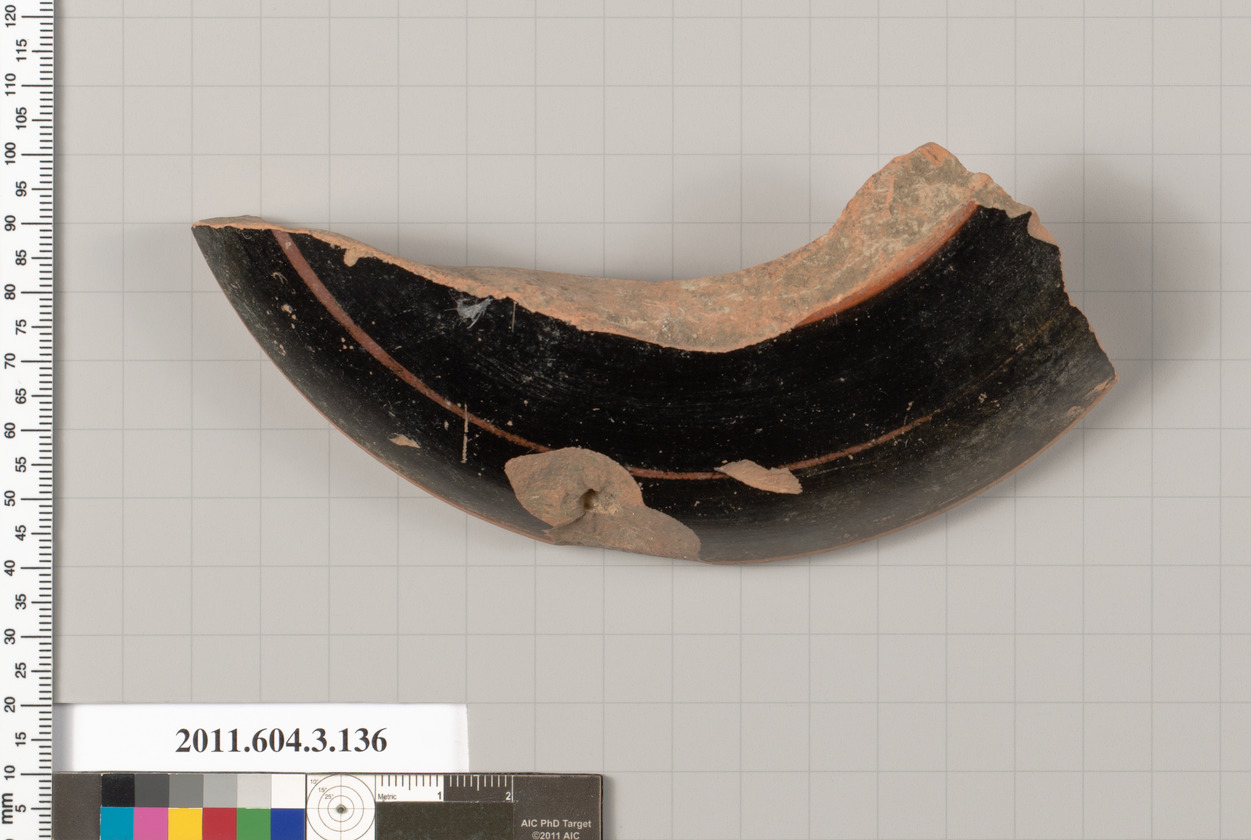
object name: amphora fragment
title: Terracotta fragment of an amphora (jar)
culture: greek, attic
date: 550-501 BCE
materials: terracotta